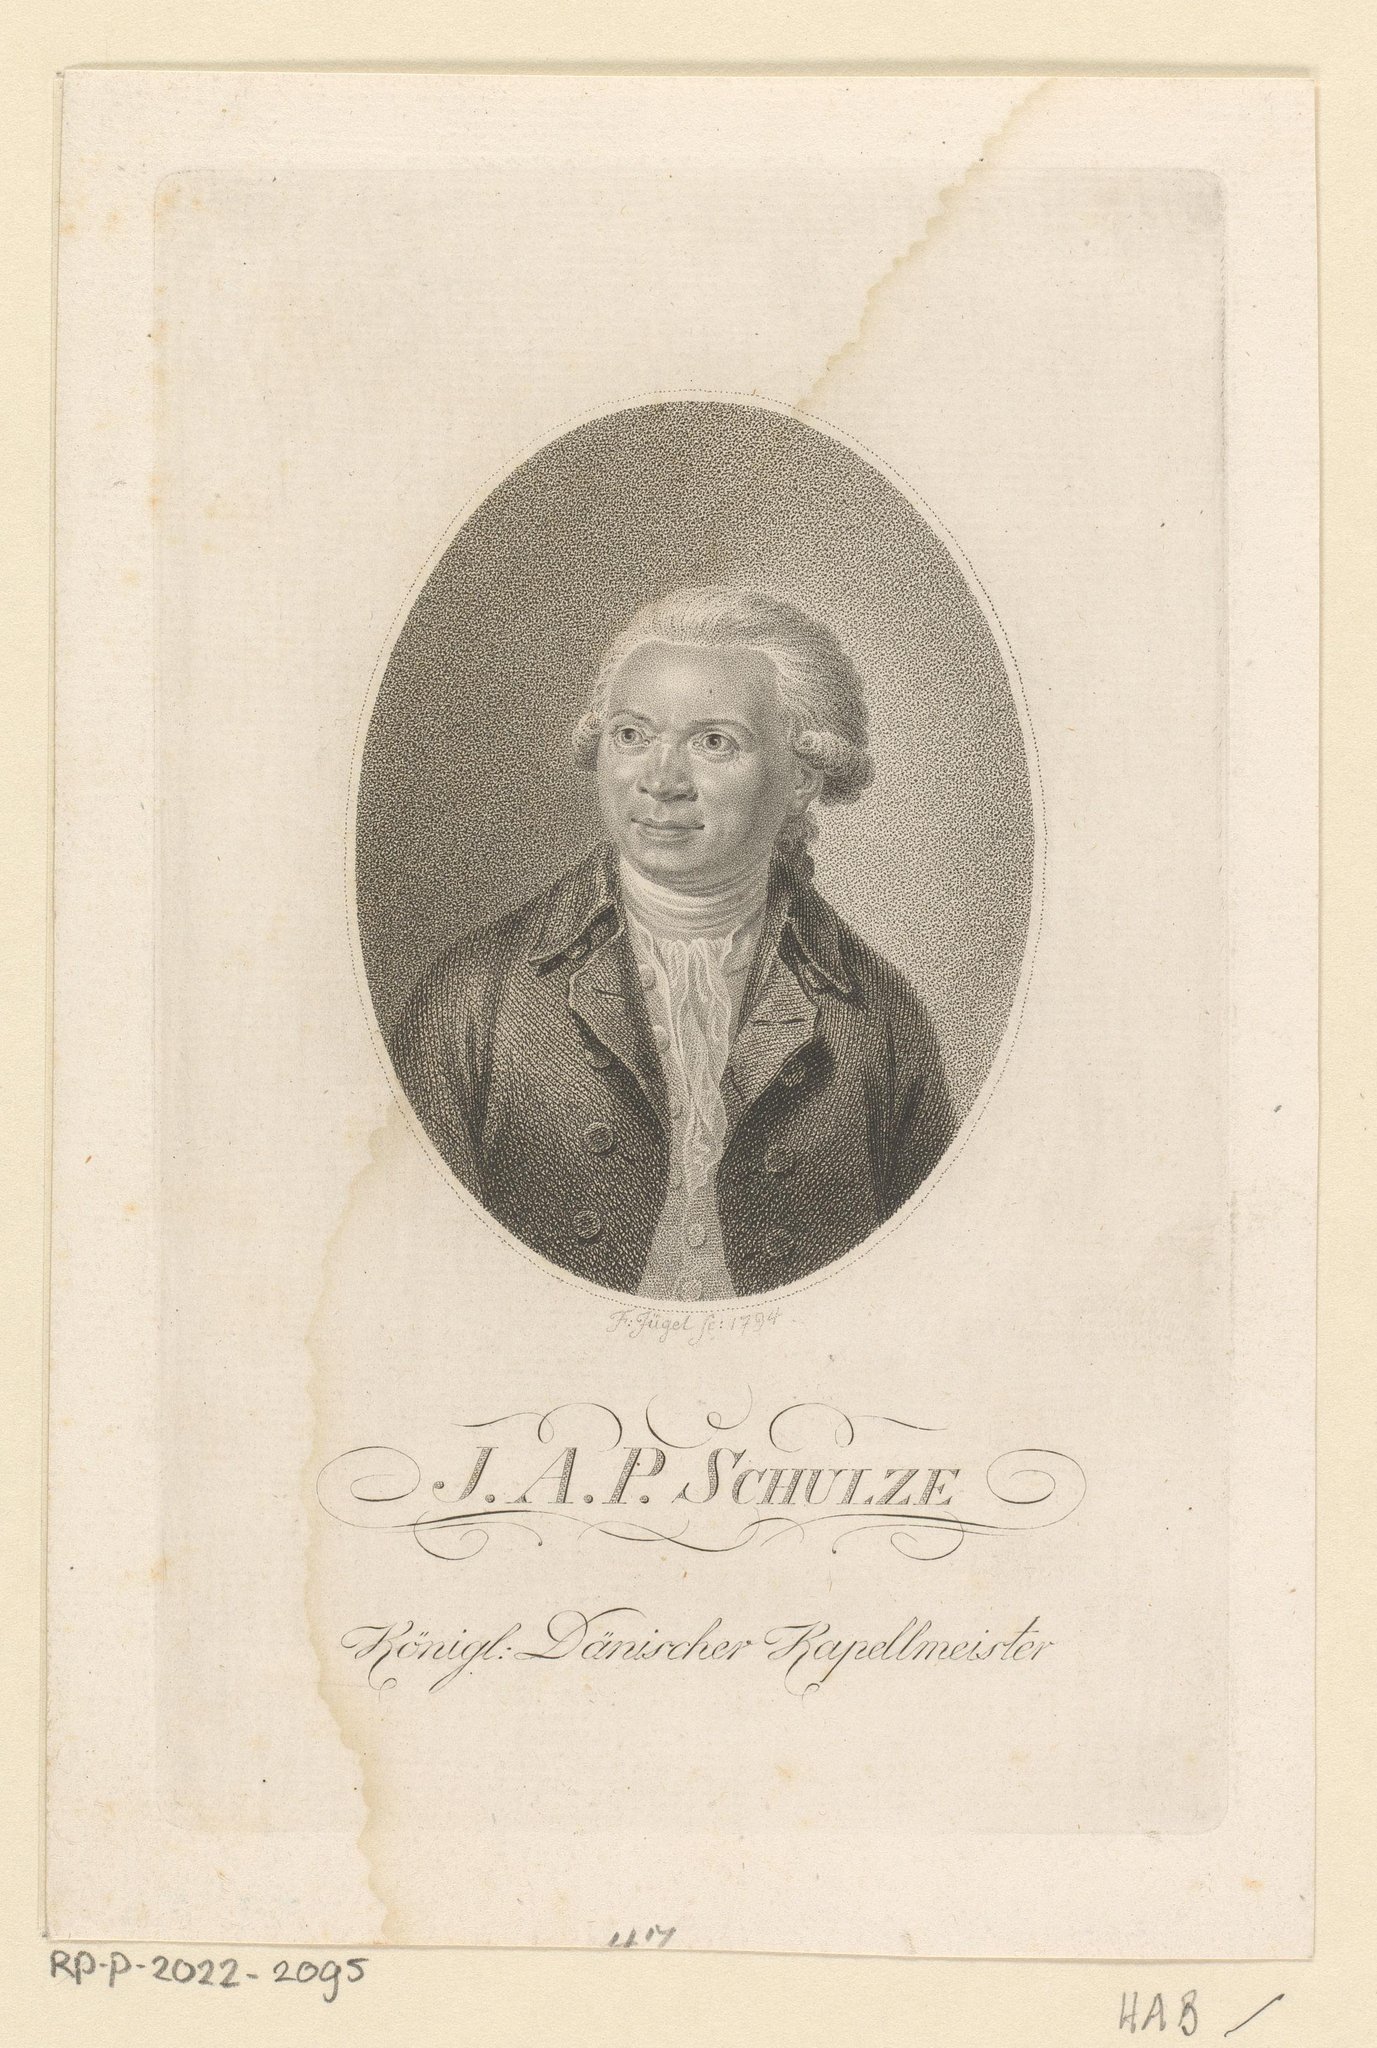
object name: print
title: Portret van Johann Abraham Peter Schulz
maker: friedrich jügel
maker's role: print maker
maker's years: 1772-1833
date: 1794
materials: paper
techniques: engraving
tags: historical persons, portrait of composer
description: Met eenregelig onderschrift in het Duits.